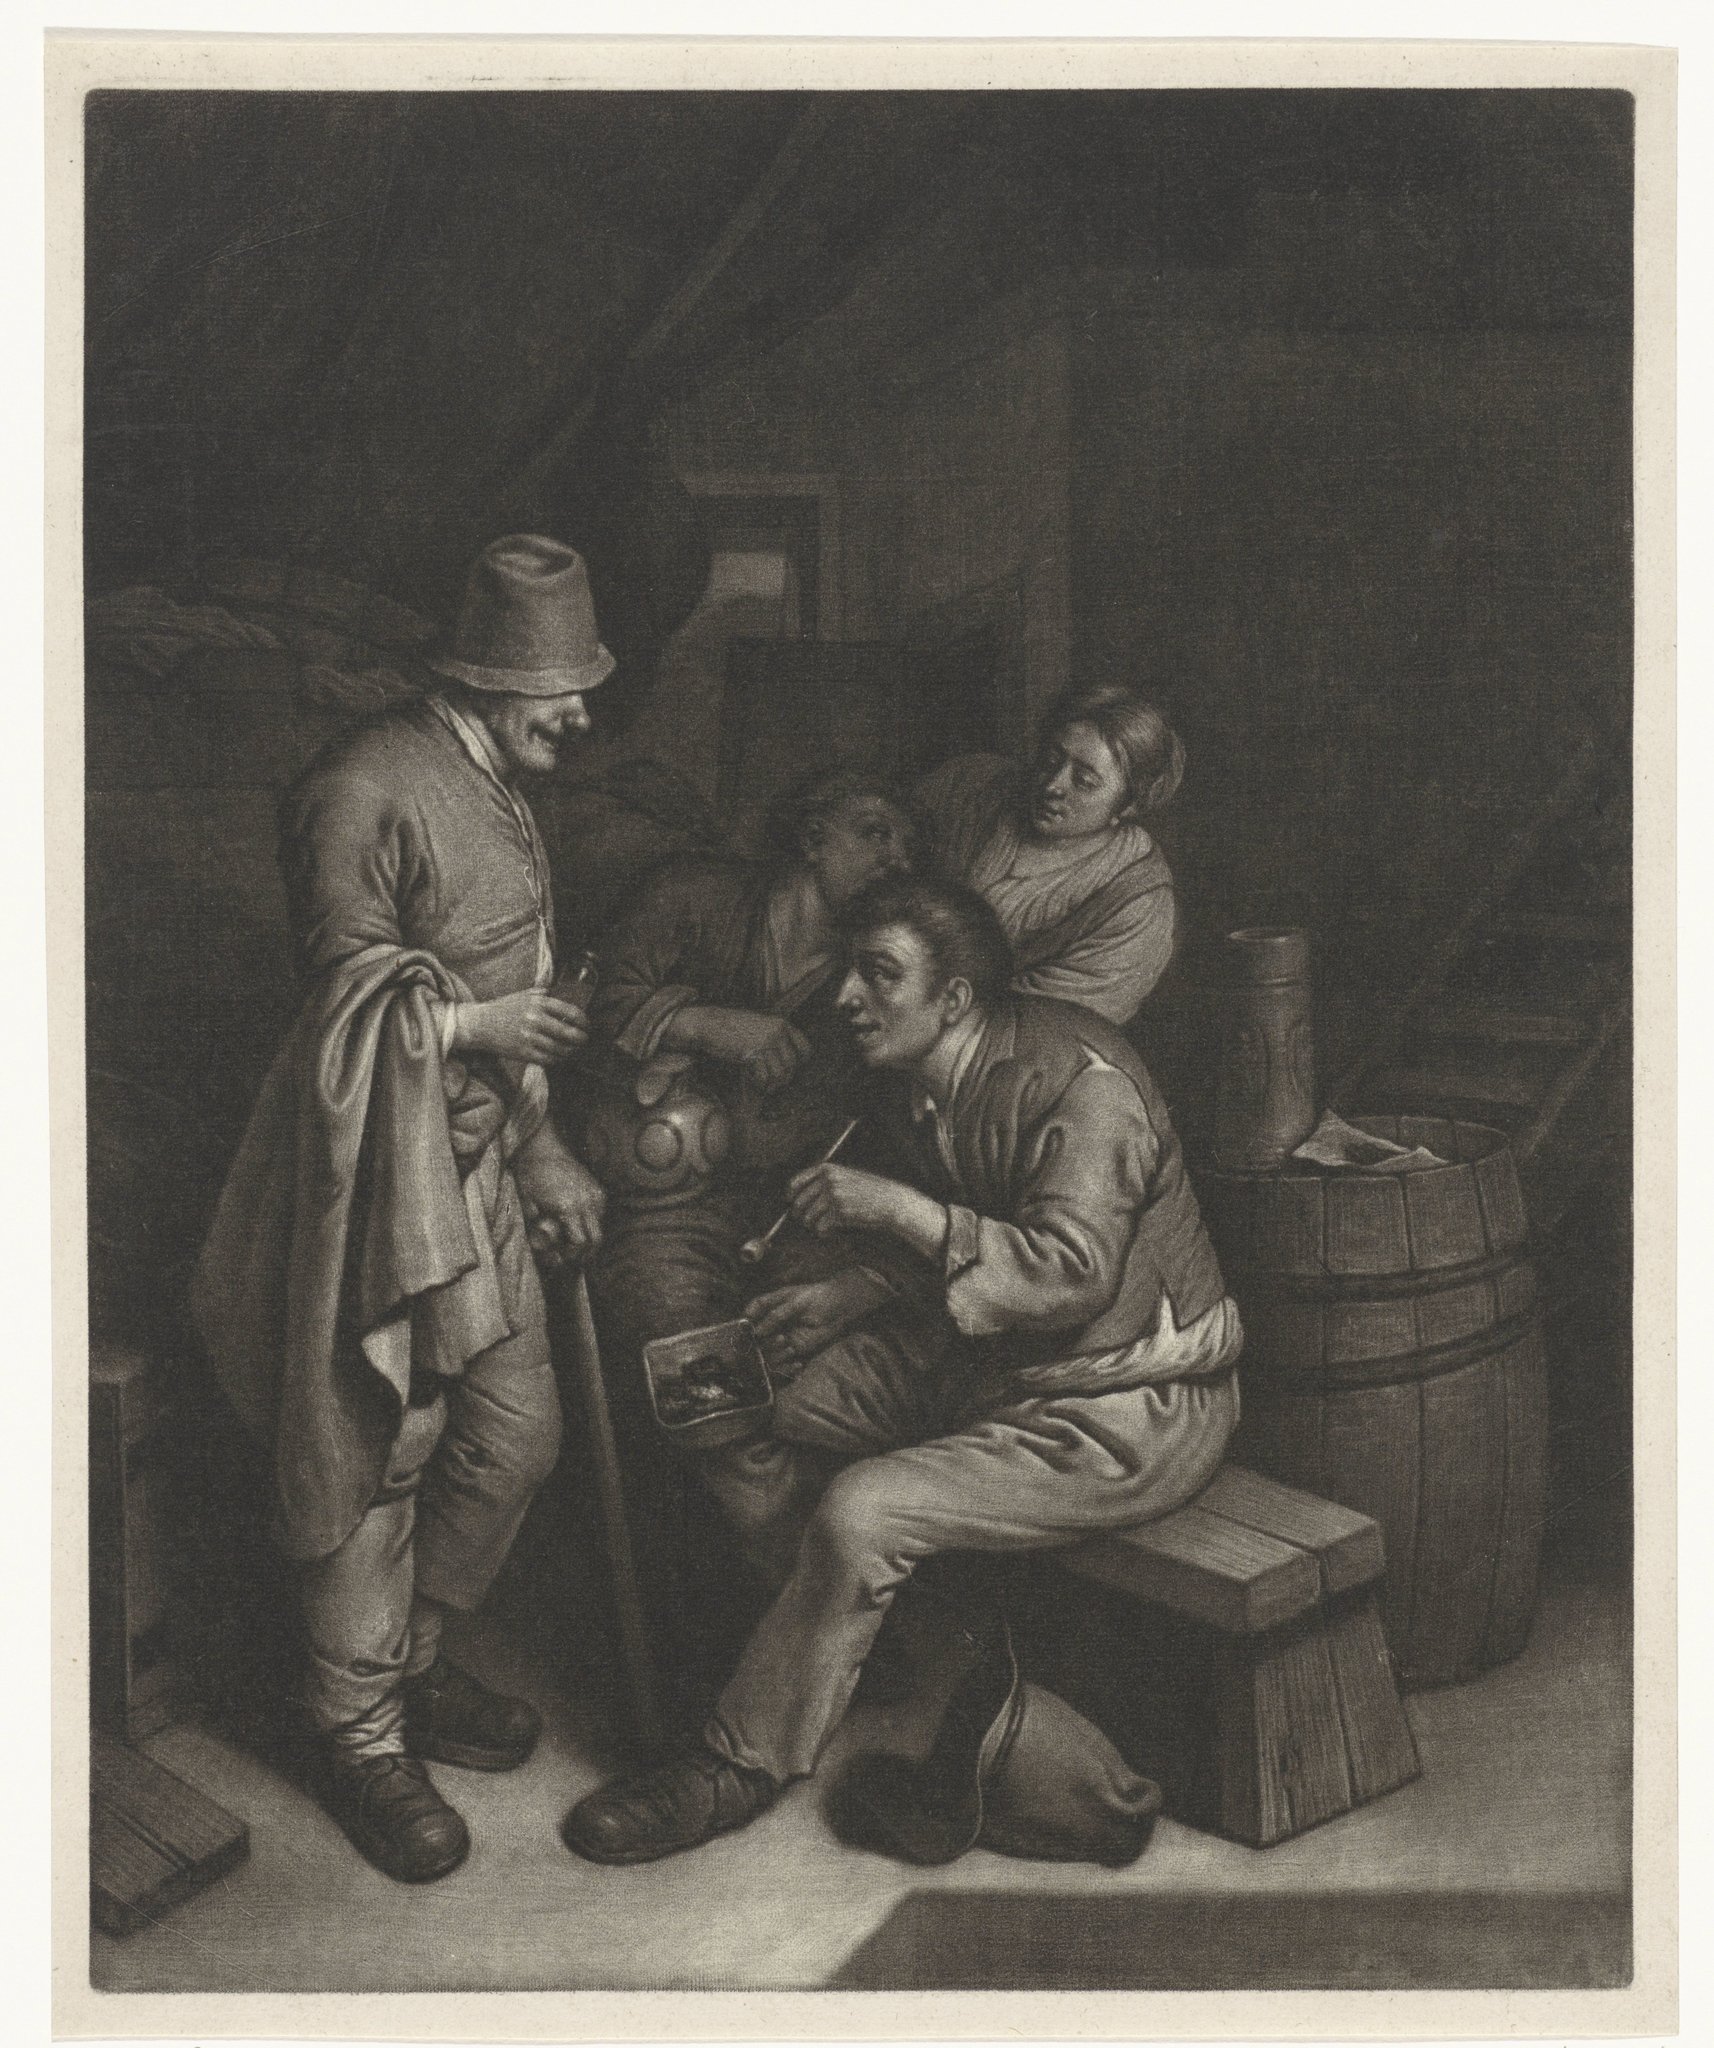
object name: print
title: Herberginterieur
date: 1658-1677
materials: paper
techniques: mezzotint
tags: inn, coffee-house, public house, etc., pipe ~ tobacco, head-gear: hat (+ men's clothes)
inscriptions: collector's mark: Lugt 2228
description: Herberginterieur met twee mannen die onder het genot van een pijp en een flesje drank een gesprek voeren. Op de achtergrond een man en een vrouw.